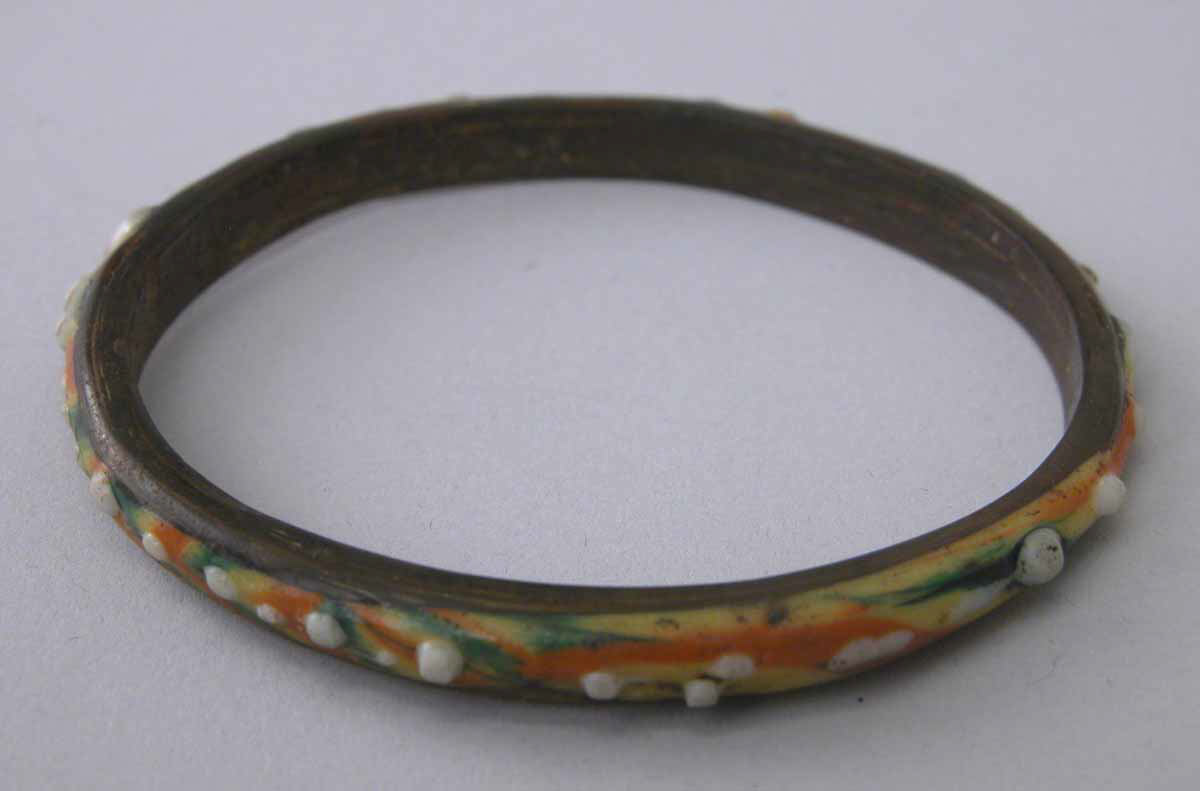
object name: bracelet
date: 1301-1500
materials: glass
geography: egypt or syria